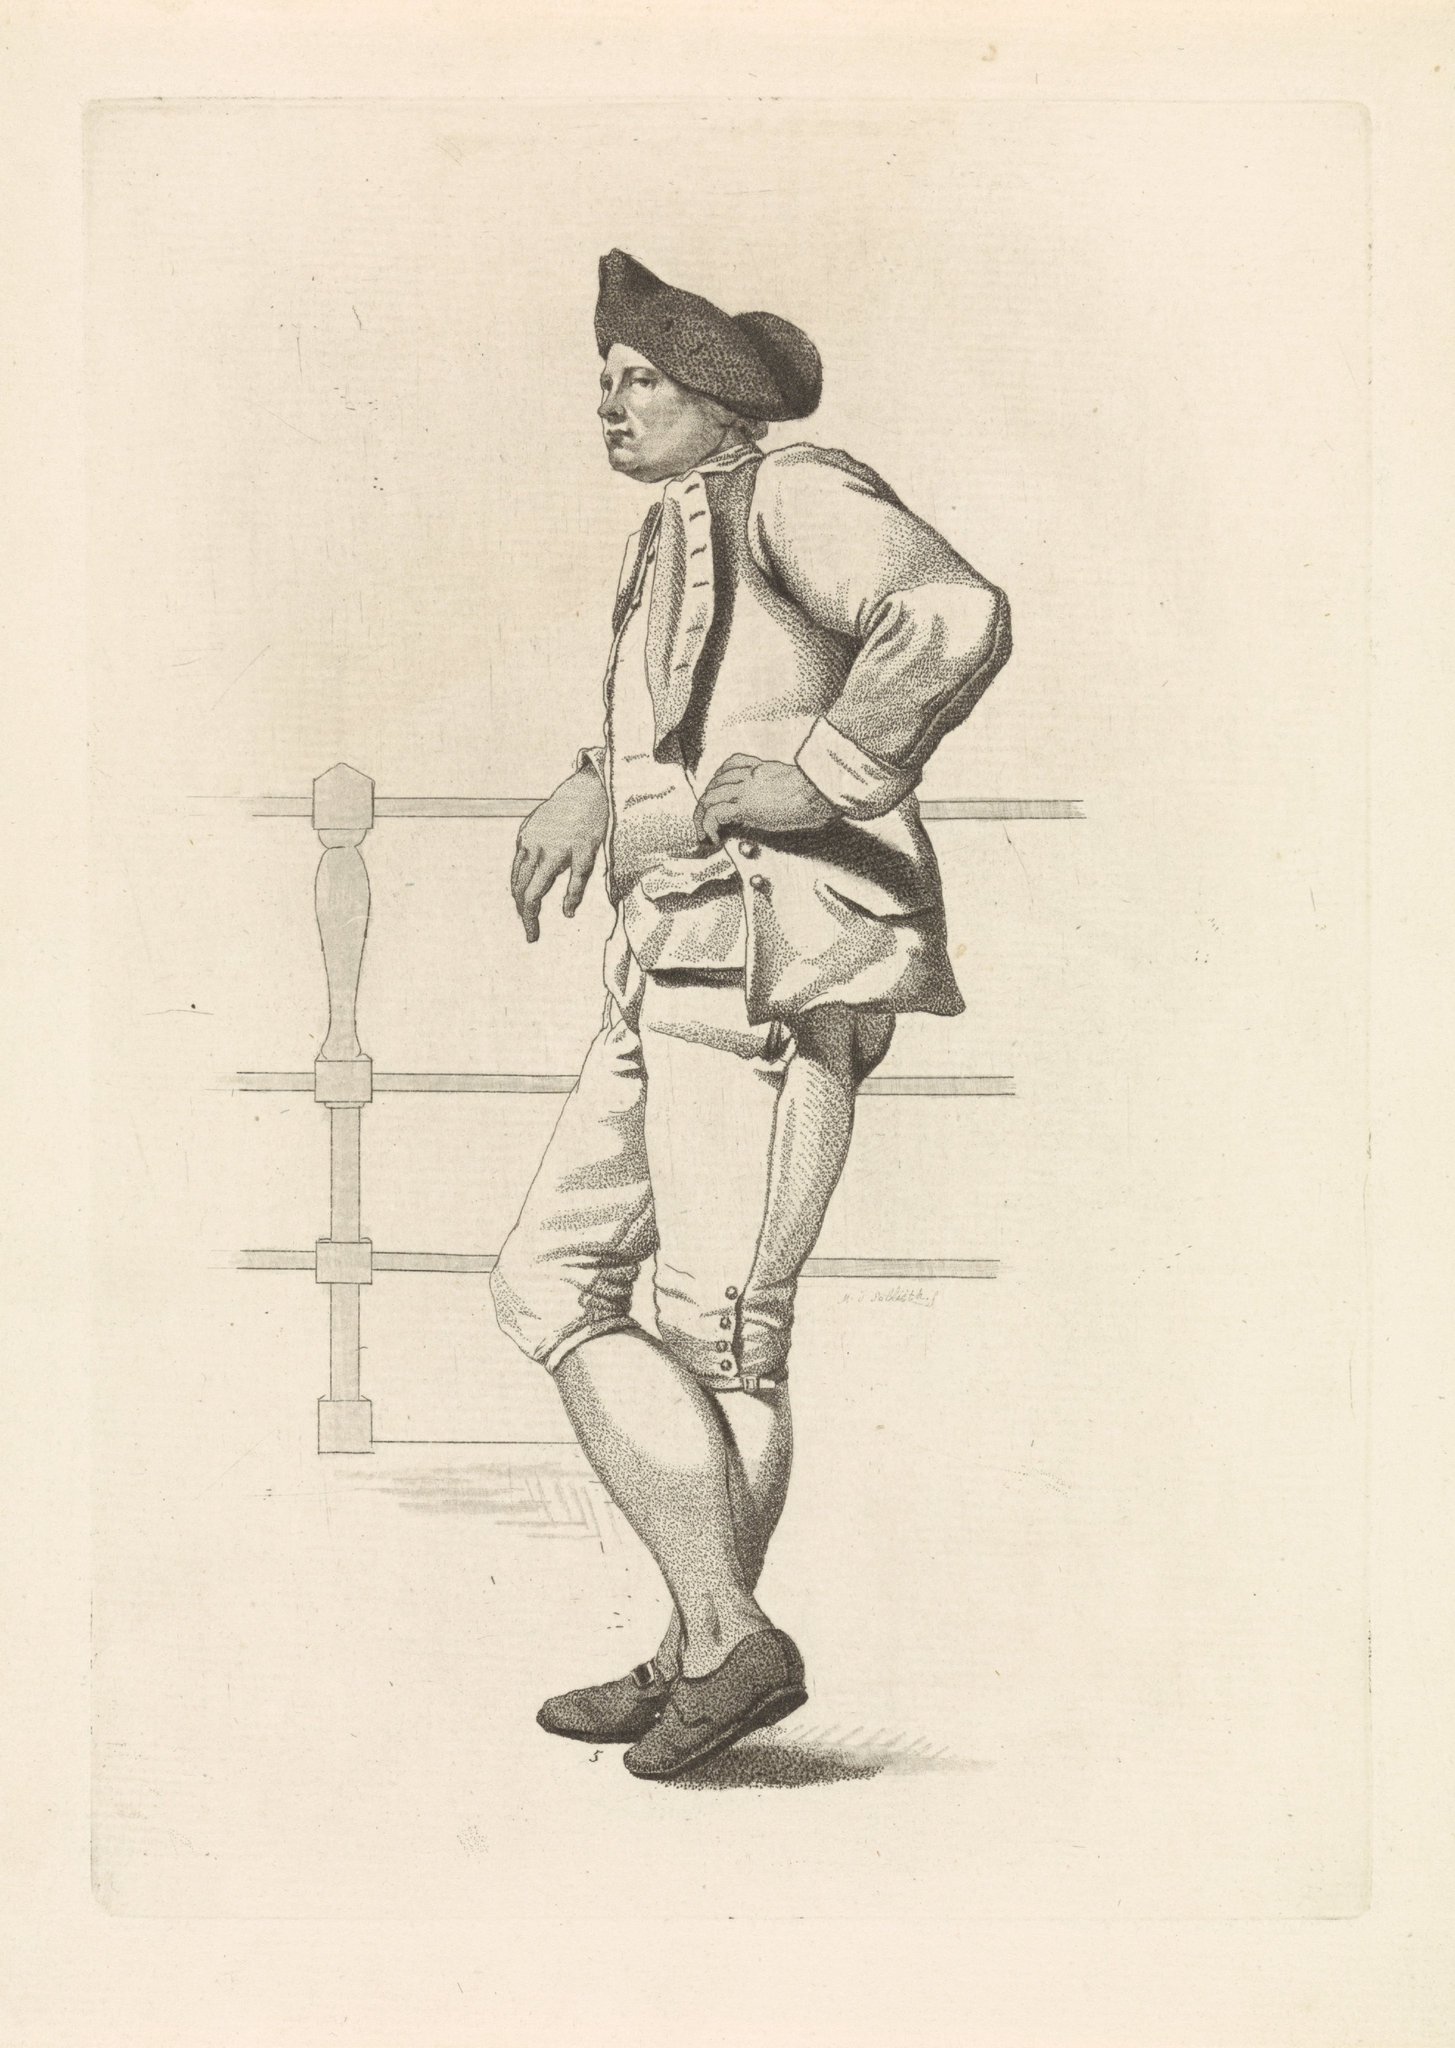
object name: print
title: Staande man, leunend tegen een hek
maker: mathias de sallieth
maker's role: print maker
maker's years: 1749-1791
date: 1772-1791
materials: paper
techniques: printmaking, etching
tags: fence, wall, paling, leaning sideways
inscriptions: collector's mark: Lugt 2228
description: De prent verscheen vanaf 1818 tevens als onderdeel van een 33-delige reeks prenten door Mathias de Sallieth, samengebonden in: Perkois, Jacobus, Prins, Johannes Huibert. Verzameling van verschillende gekleede mans- en vrouwenstanden, ter oefening van jonge schilders en liefhebbers. Rotterdam: Johannes Immerzeel, 1818.